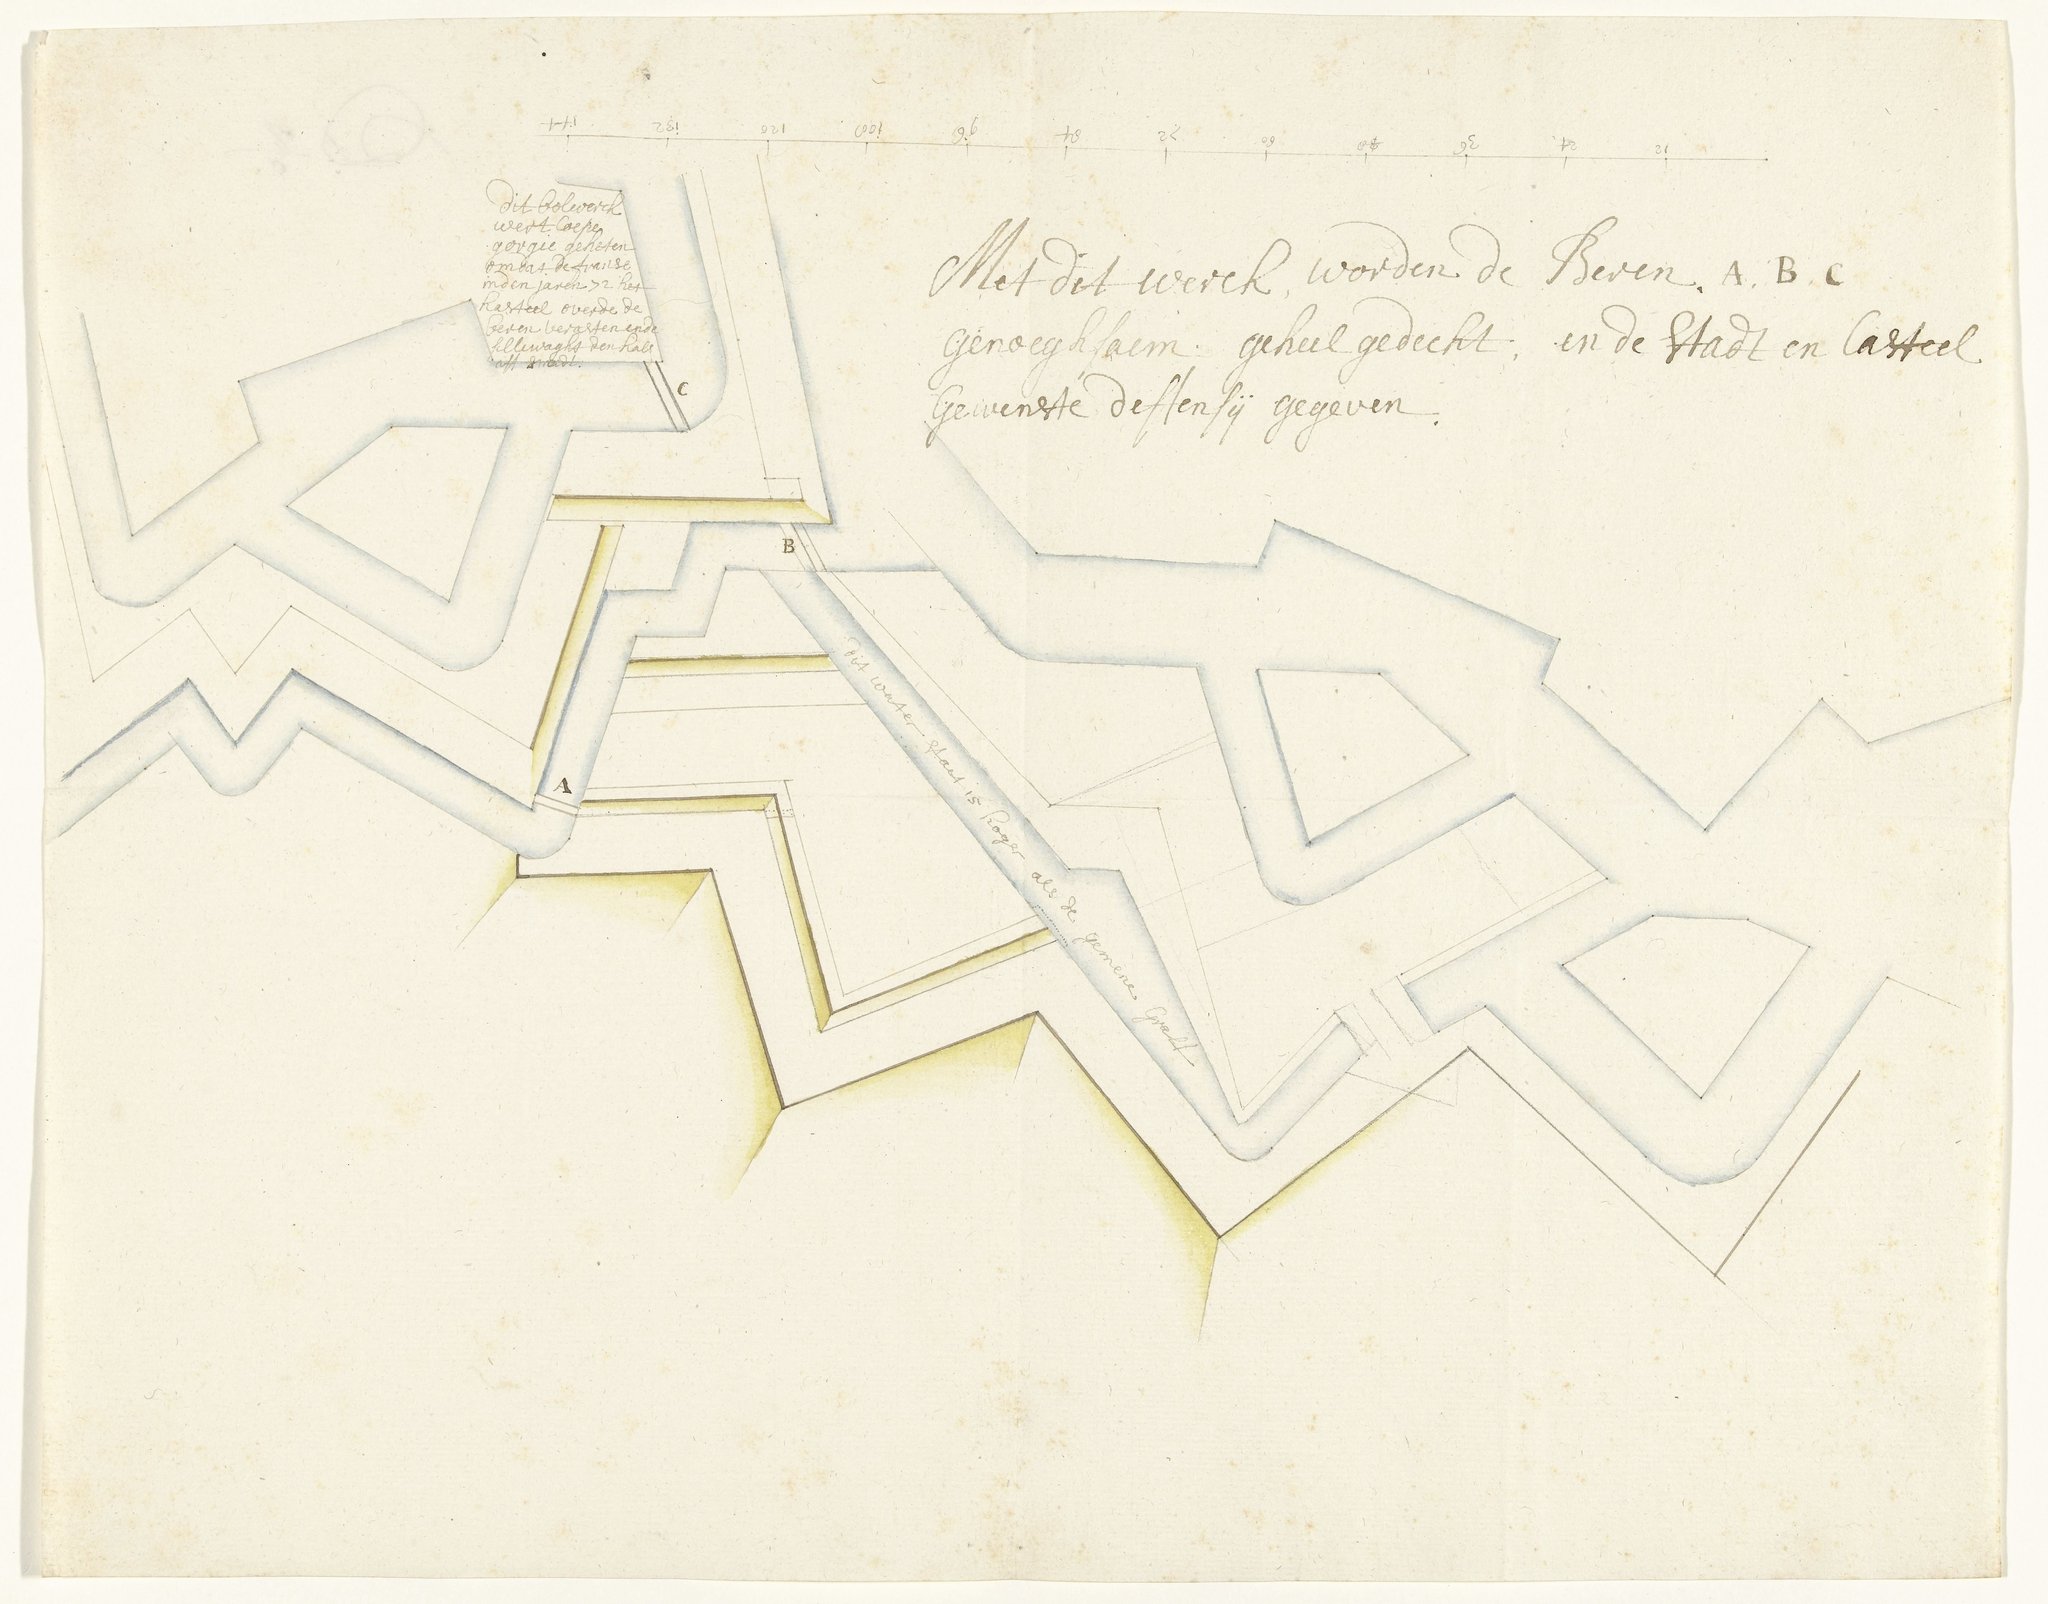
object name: map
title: Platte Gront der stadt en Casteel Sout Leeu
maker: samuel du ry de champdoré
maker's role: draughtsman, engineer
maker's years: 1651-1729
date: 1705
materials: paper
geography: netherlands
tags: fortress, zoutleeuw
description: Detailstudie van enkele bolwerken van de stad, belegerd en ingenomen door de Geallieerden op 5 augustus 1705. Blad ligt los in het album. Onderdeel van een verzameling getekende plannen van versterkte plaatsen in Nederland en omringende landen ten tijde van de Spaanse Successieoorlog (deel D).